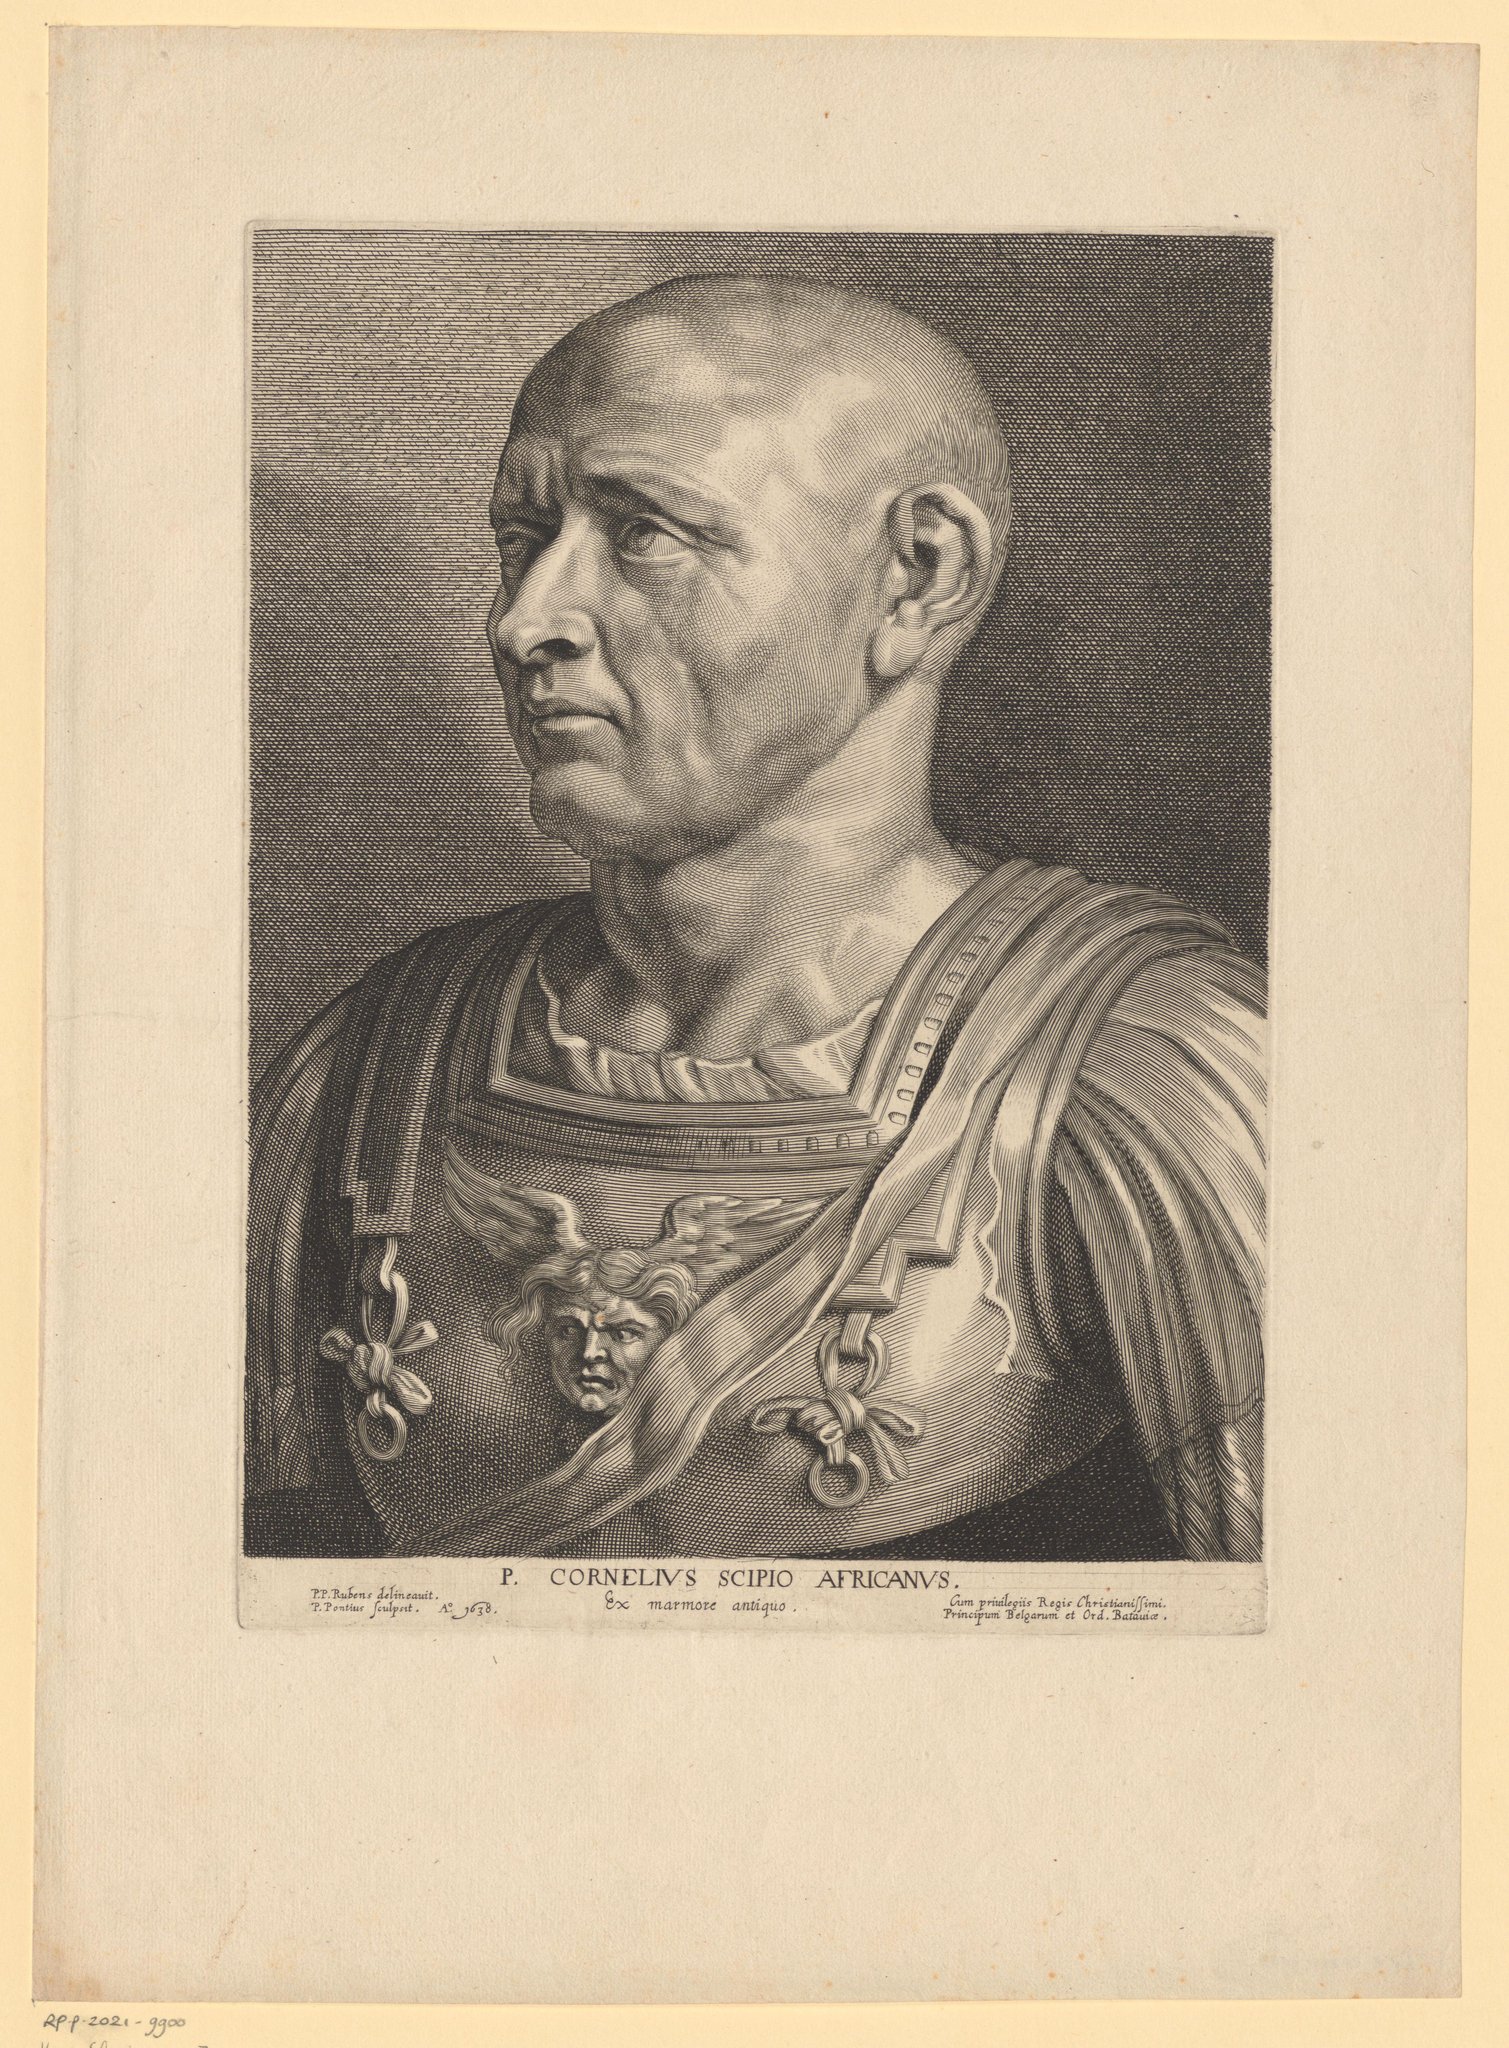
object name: print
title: P. Cornelivs Scipio Africanvs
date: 1638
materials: paper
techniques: engraving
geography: antwerp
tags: rome, politician, historical persons, piece of sculpture, reproduction of a piece of sculpture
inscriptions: watermark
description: Deze prent behoort tot een serie met twaalf portretten van bekende Griekse en Romeinse mannen, vervaardigd door Paulus Pontius, B. Bolswert, L. Vorsterman en H. Withouc.